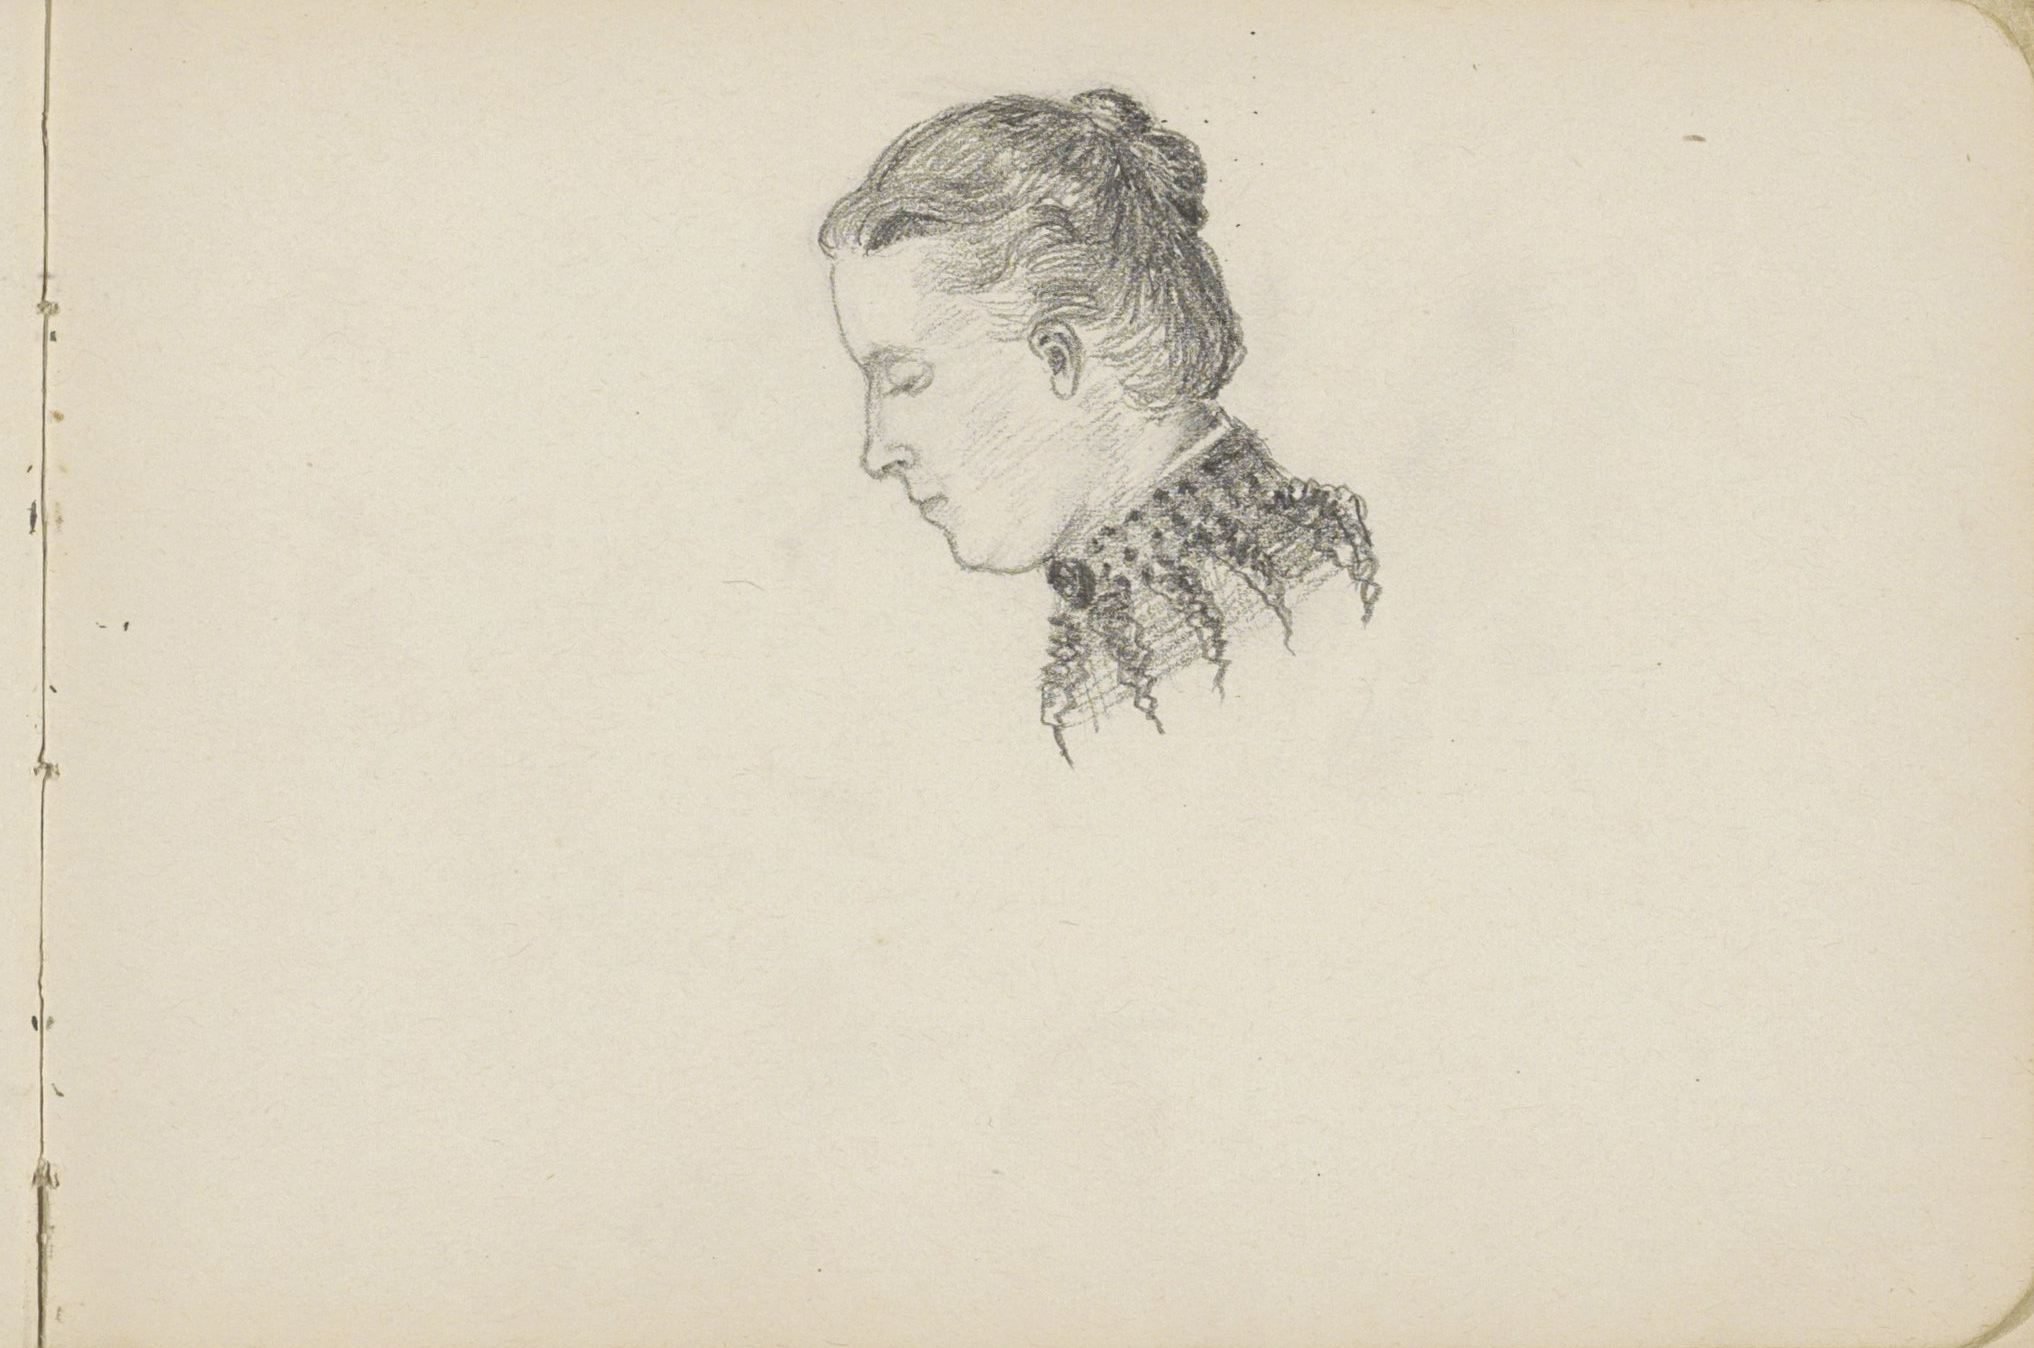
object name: sketchbook leaf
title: Vrouwenkop, in profiel naar links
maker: julie de graag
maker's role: draughtsman, print maker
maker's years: 1877-1924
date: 1894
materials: paper, pencil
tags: head (human), adult woman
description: Blad 27 recto uit een schetsboek met 35 bladen.